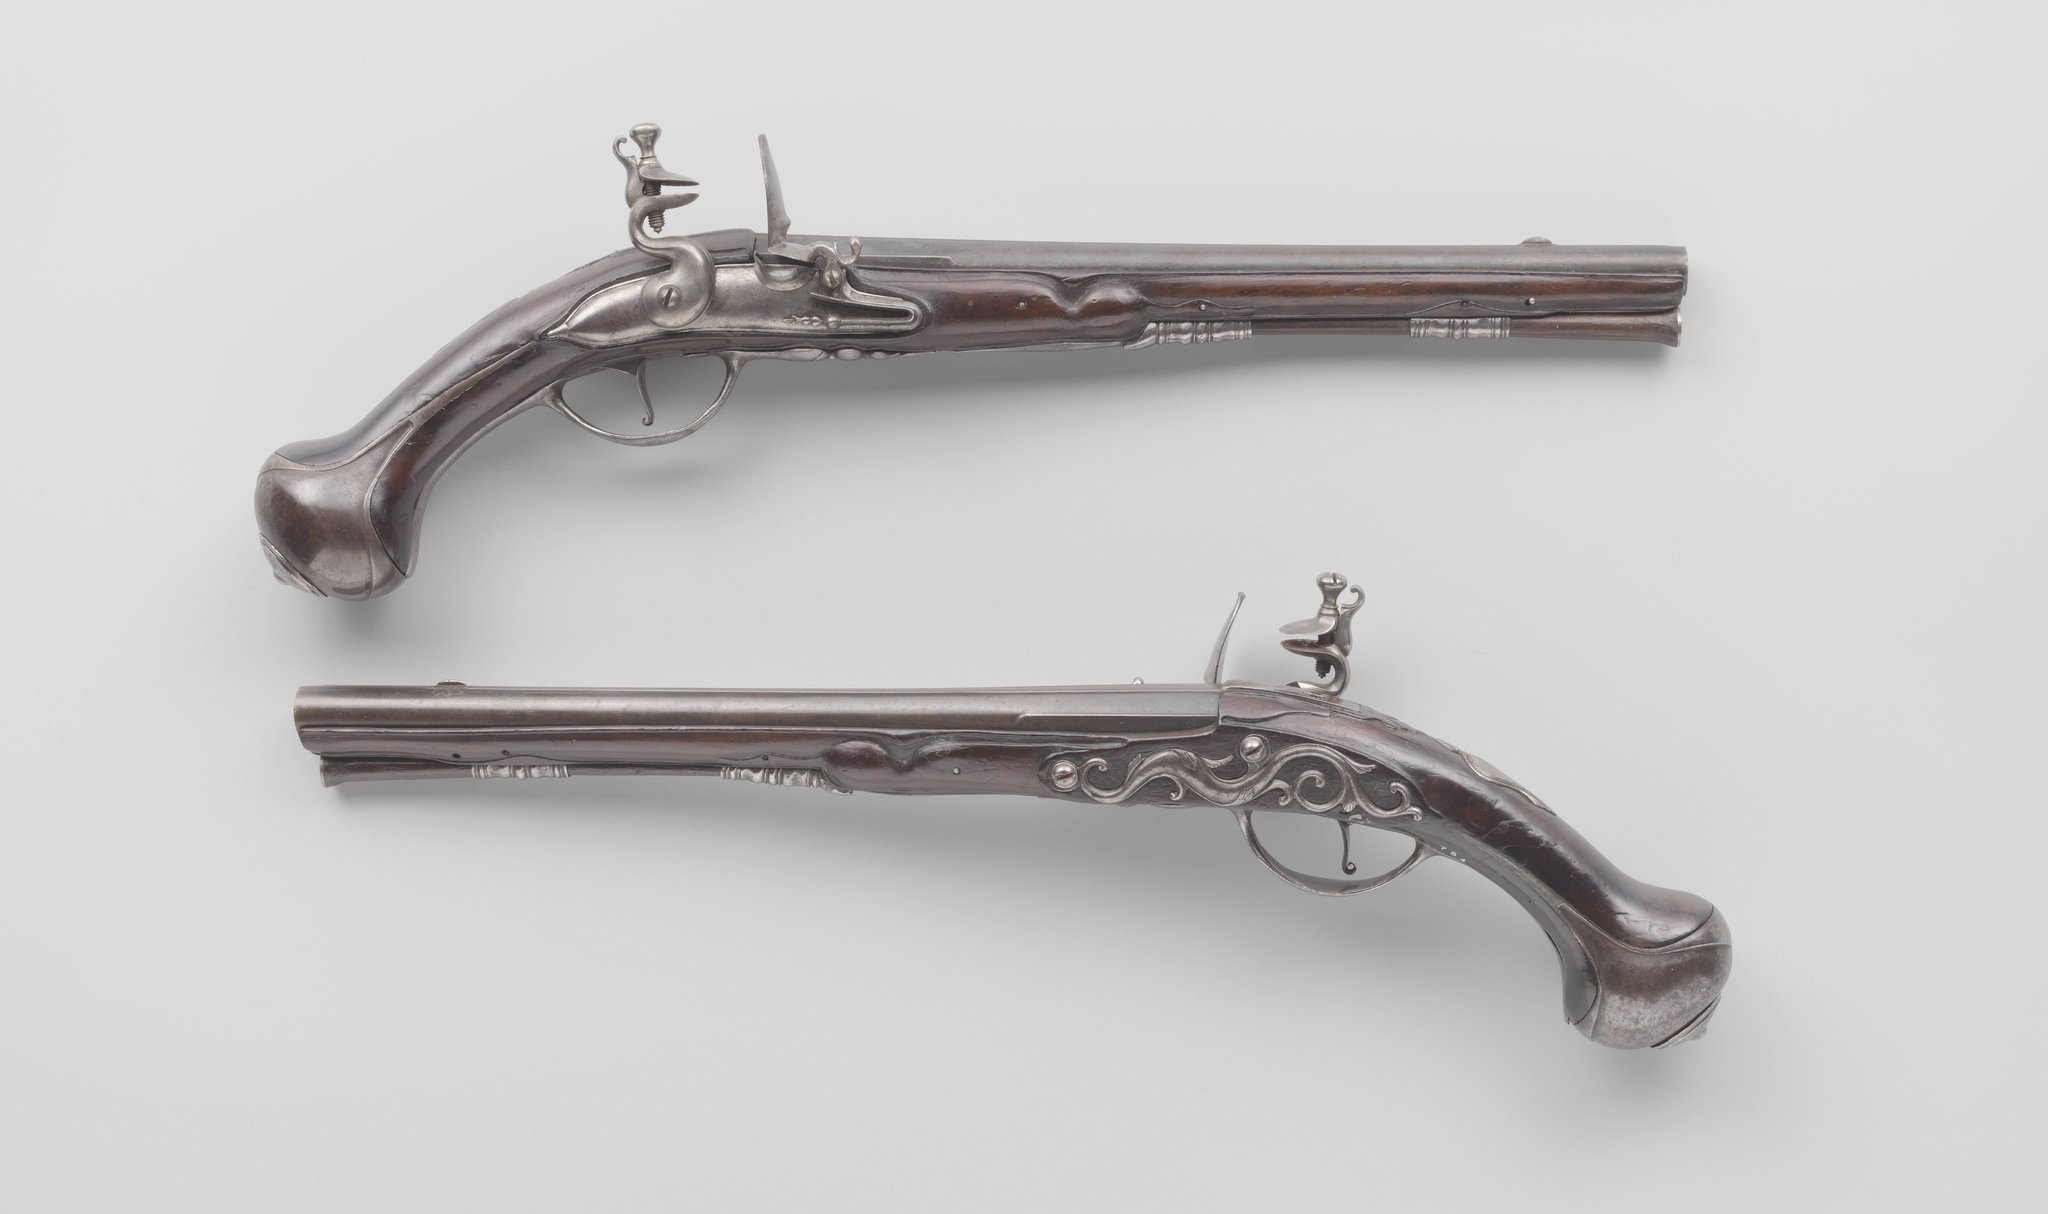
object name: flintlock pistol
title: Militair vuursteenpistool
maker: Anonymous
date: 1690-1700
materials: iron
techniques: cutting, engraving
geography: maastricht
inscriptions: inscription: ‘MASTRICH’